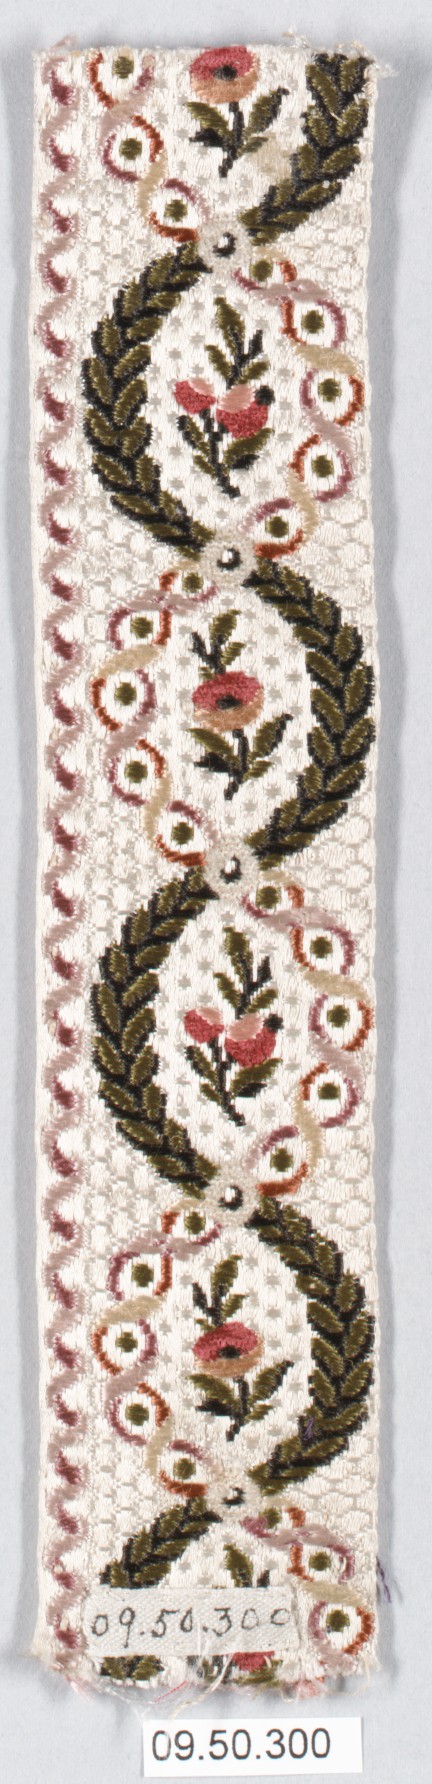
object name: ribbon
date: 1701-1800